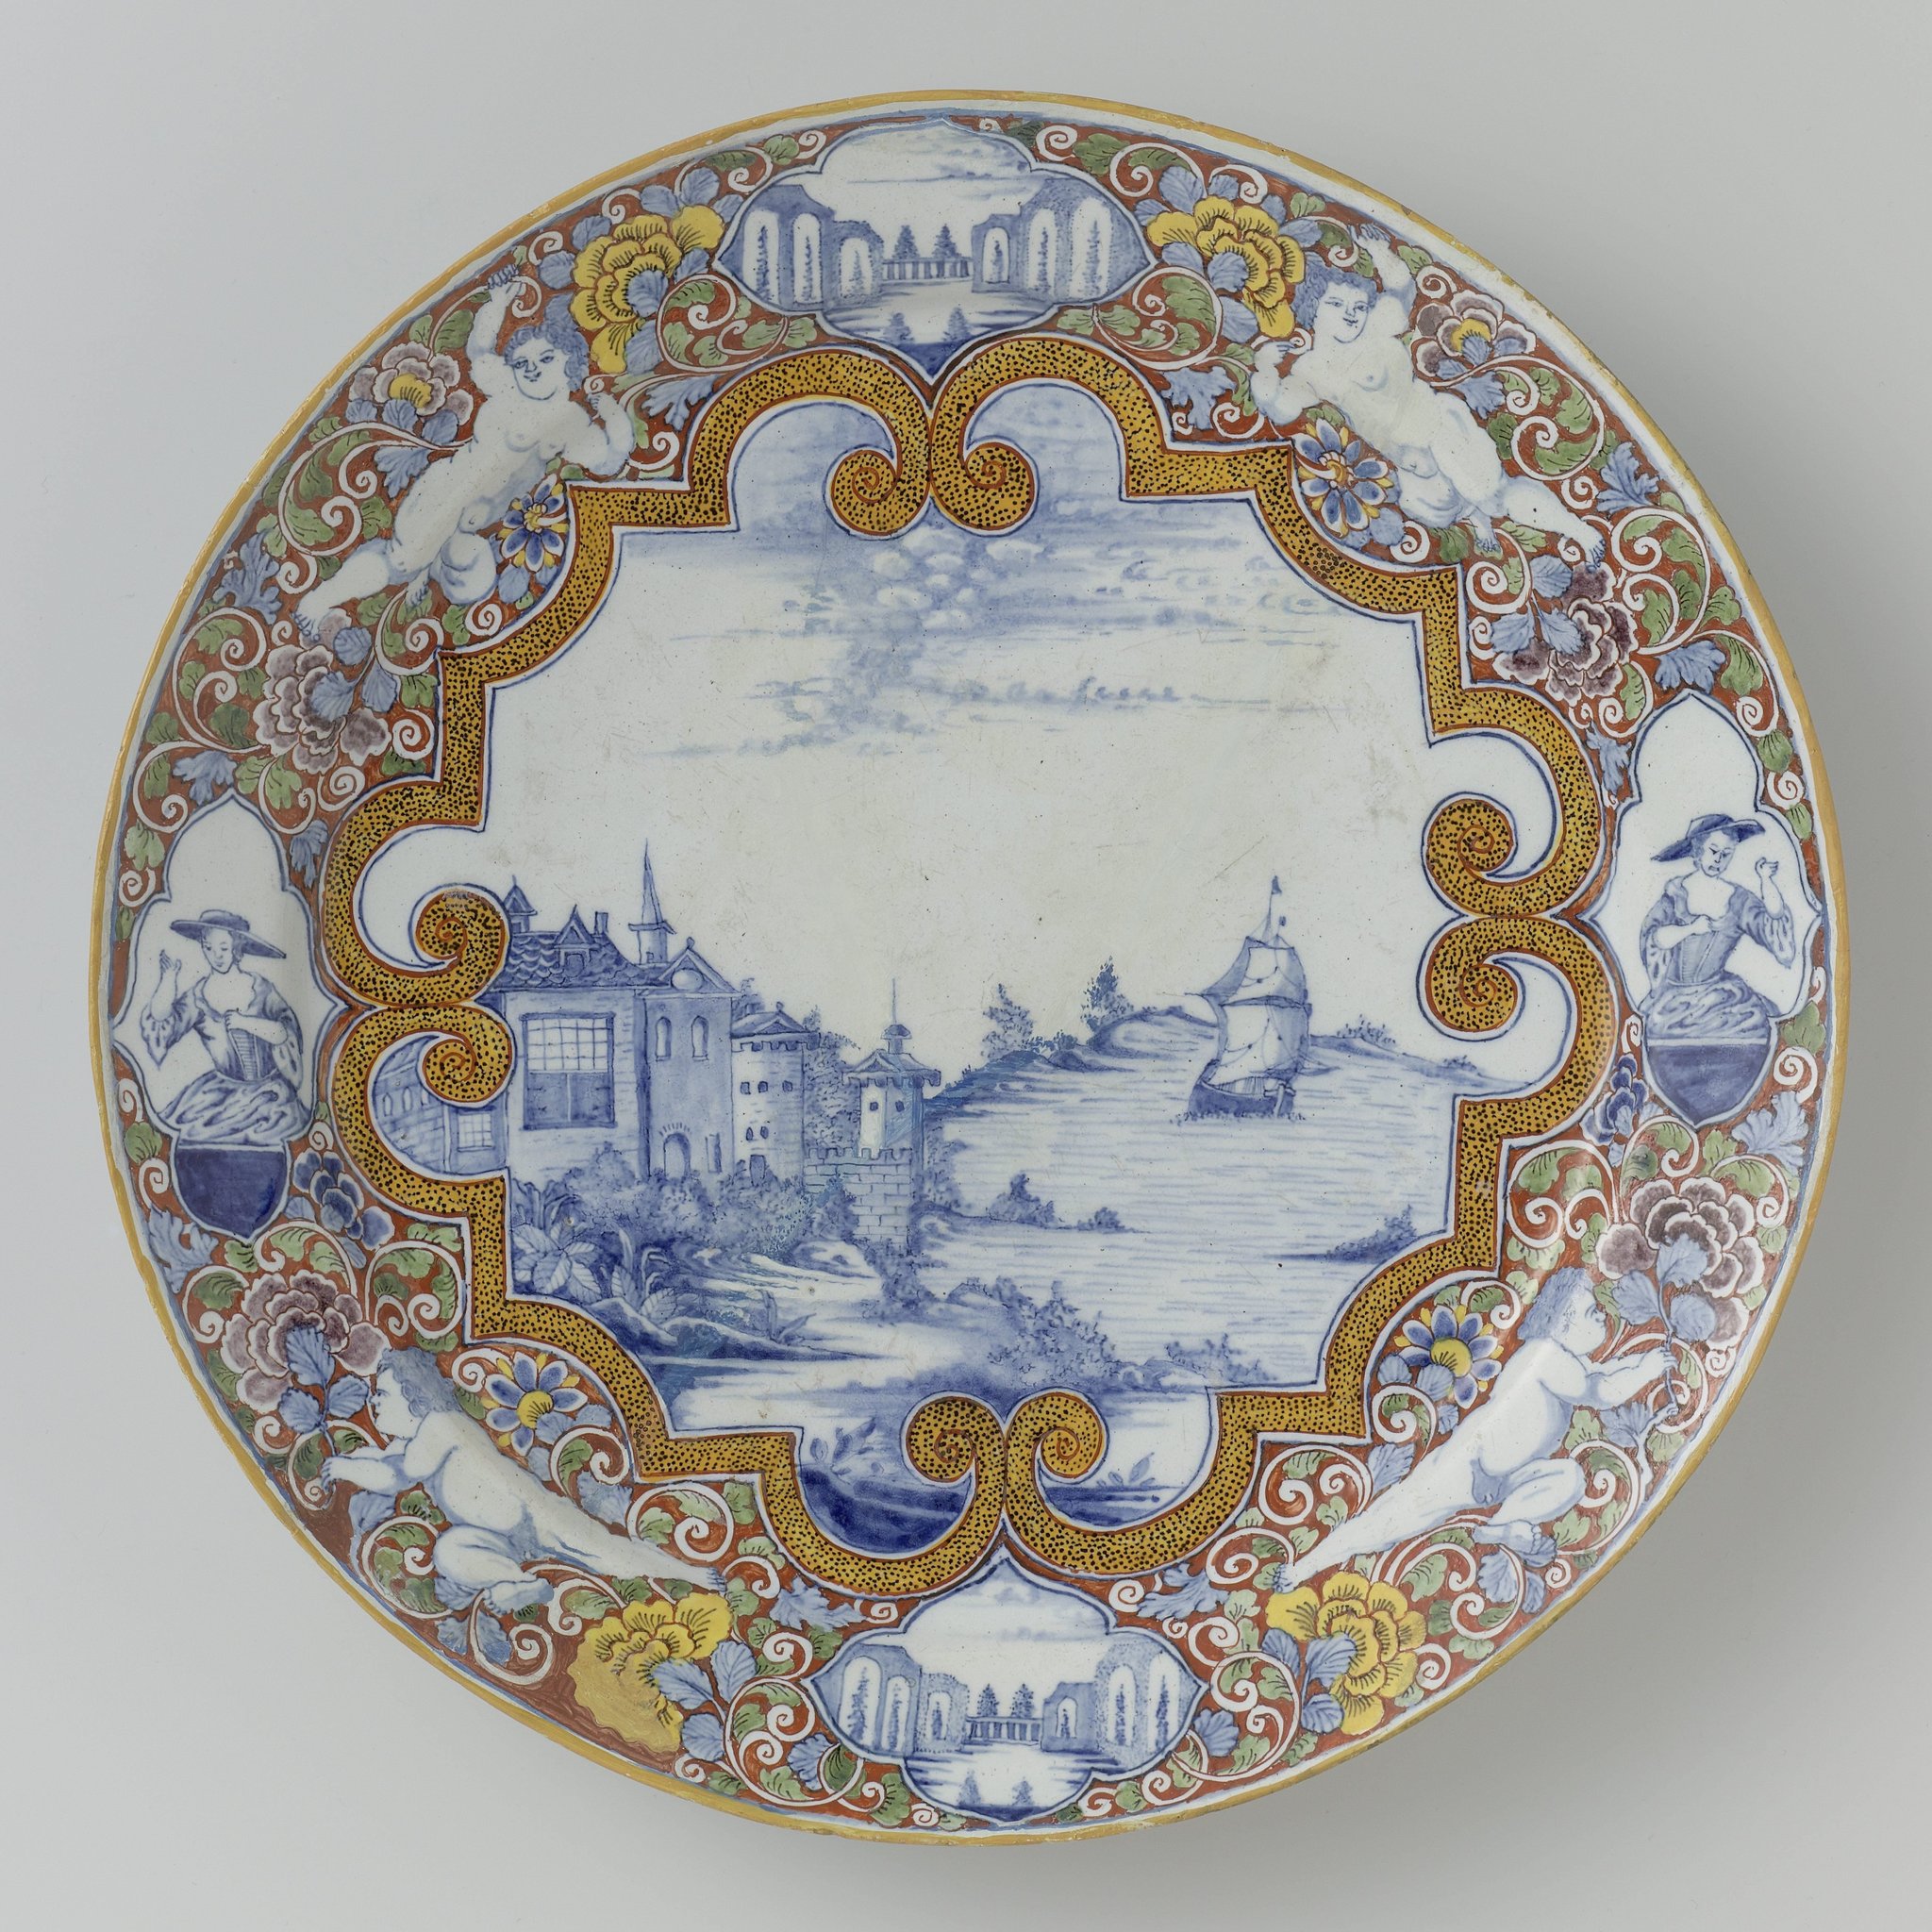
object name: platter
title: Schotel, op het plat een zeilend schip binnen een Louis XV rand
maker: Anonymous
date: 1750-1780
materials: faience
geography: delft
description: Schotel van faïence, op het plat een zeilend schip binnen een Louis XV rand. Rand veelkleurig beschilderd met bloemen, putti en vier medaillons.